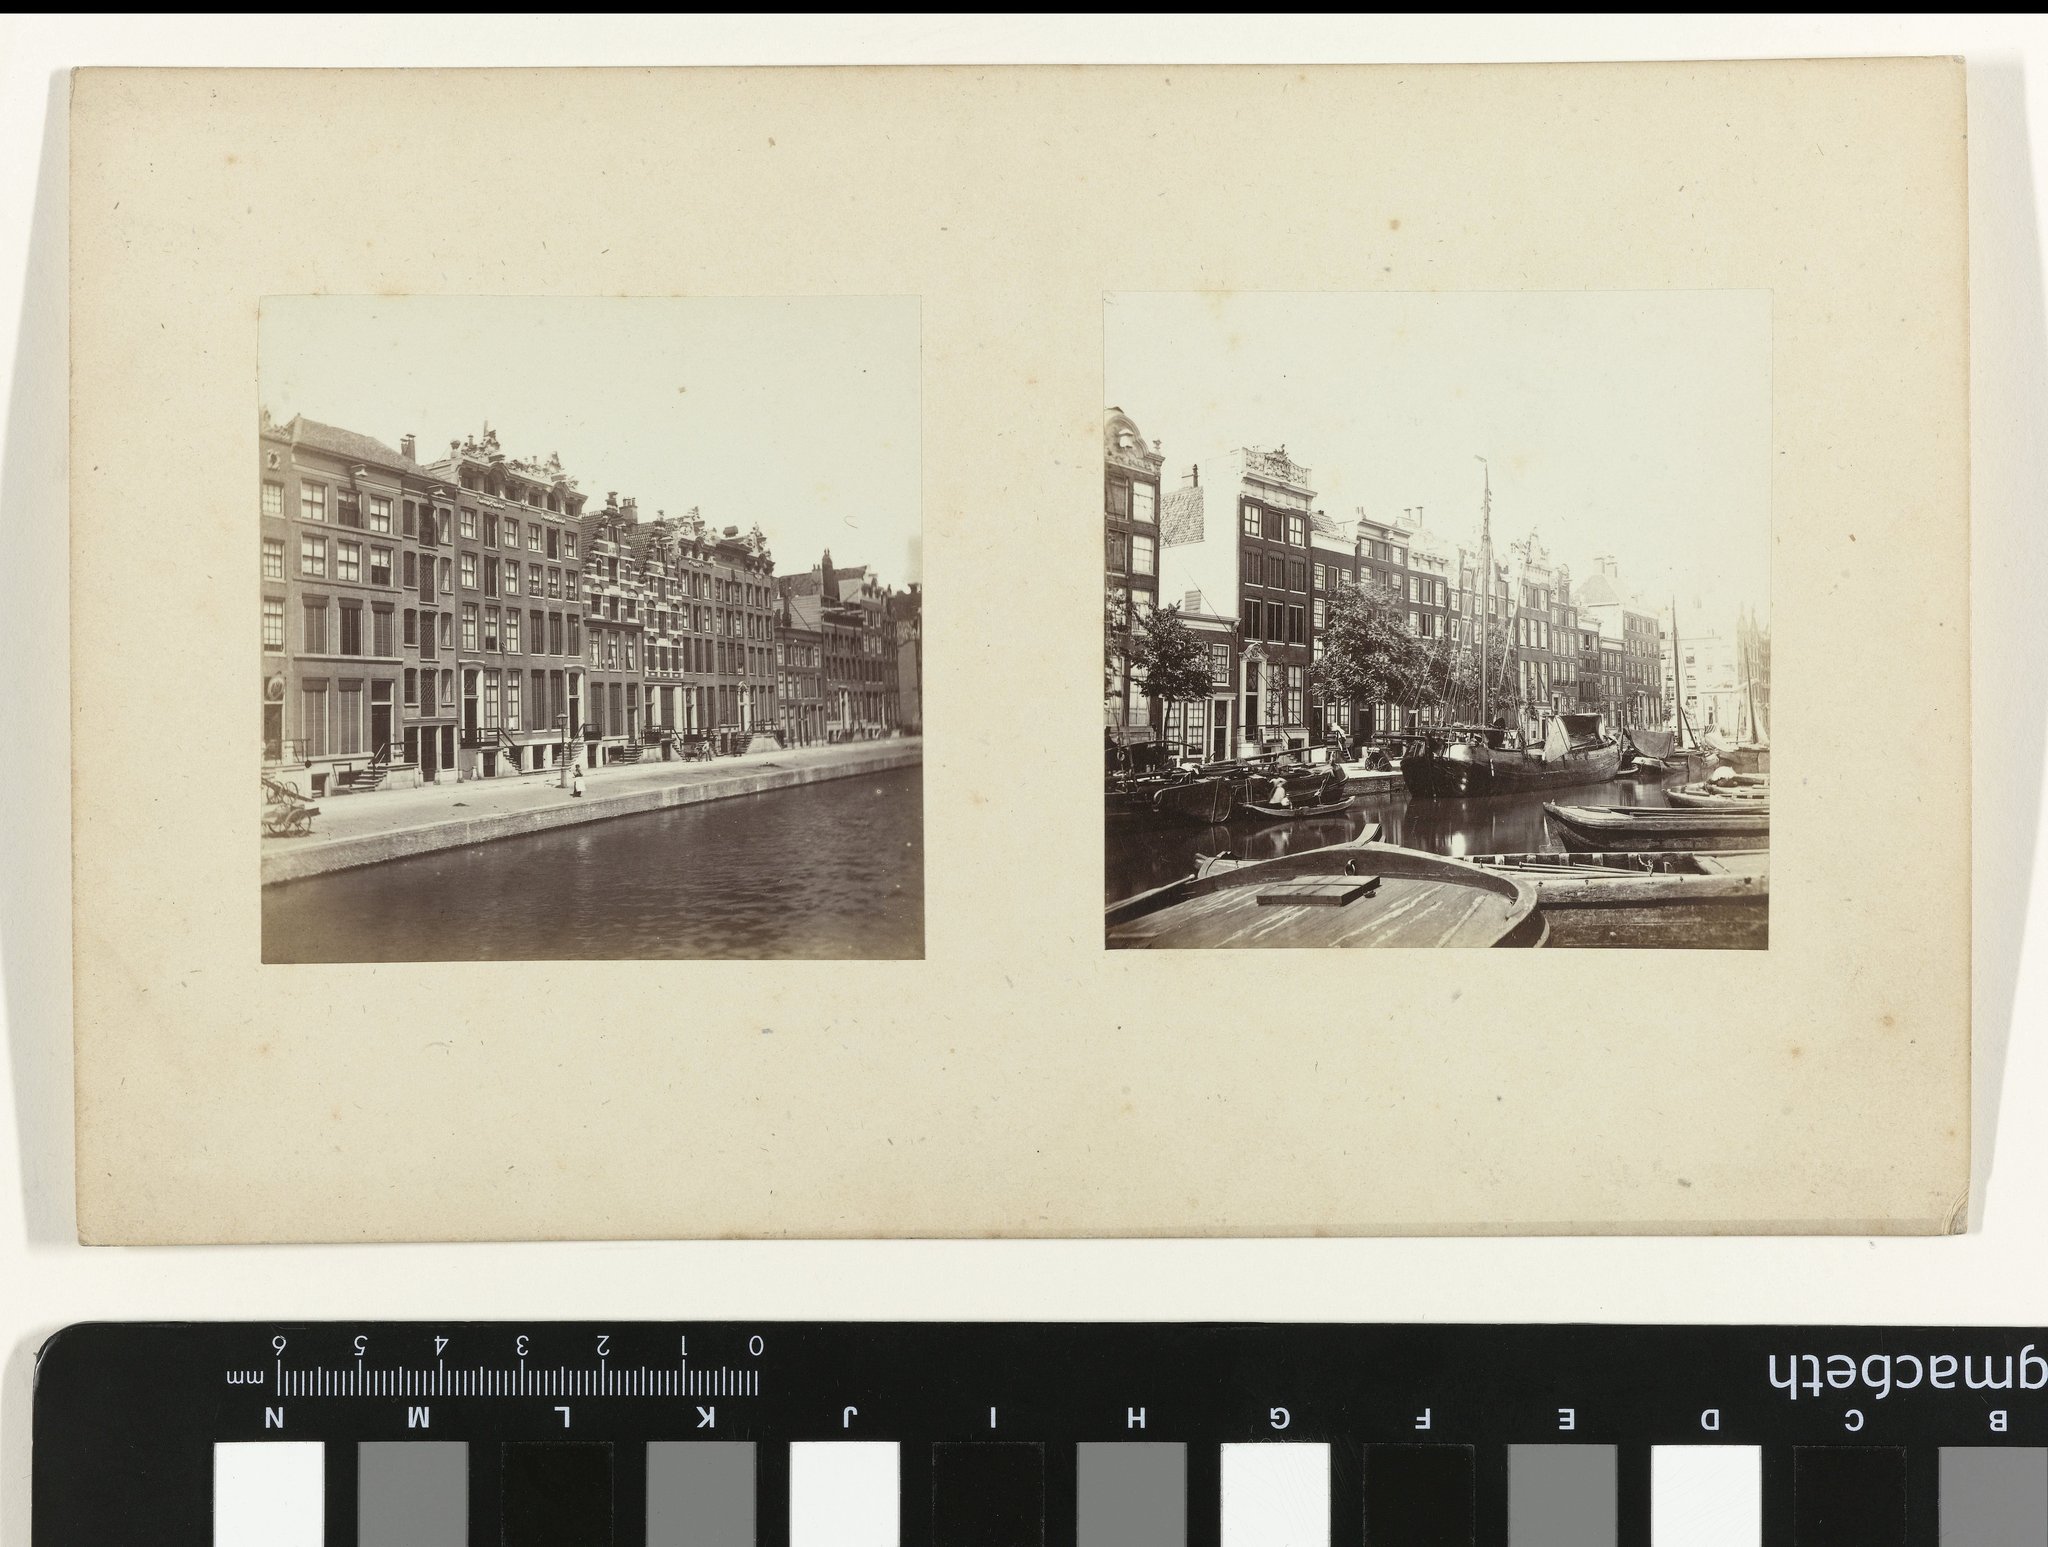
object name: photograph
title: Het Singel bij de Korsjespoortsteeg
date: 1860-1875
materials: cardboard, paper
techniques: albumen print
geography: amsterdam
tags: quay